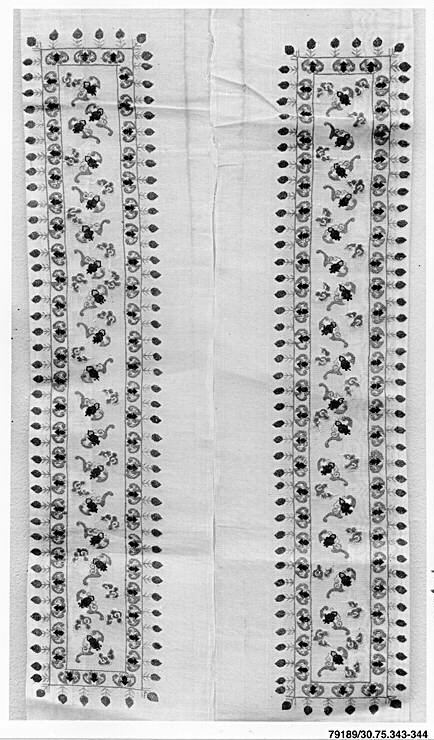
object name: sleeve band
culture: chinese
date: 1801-1900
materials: silk